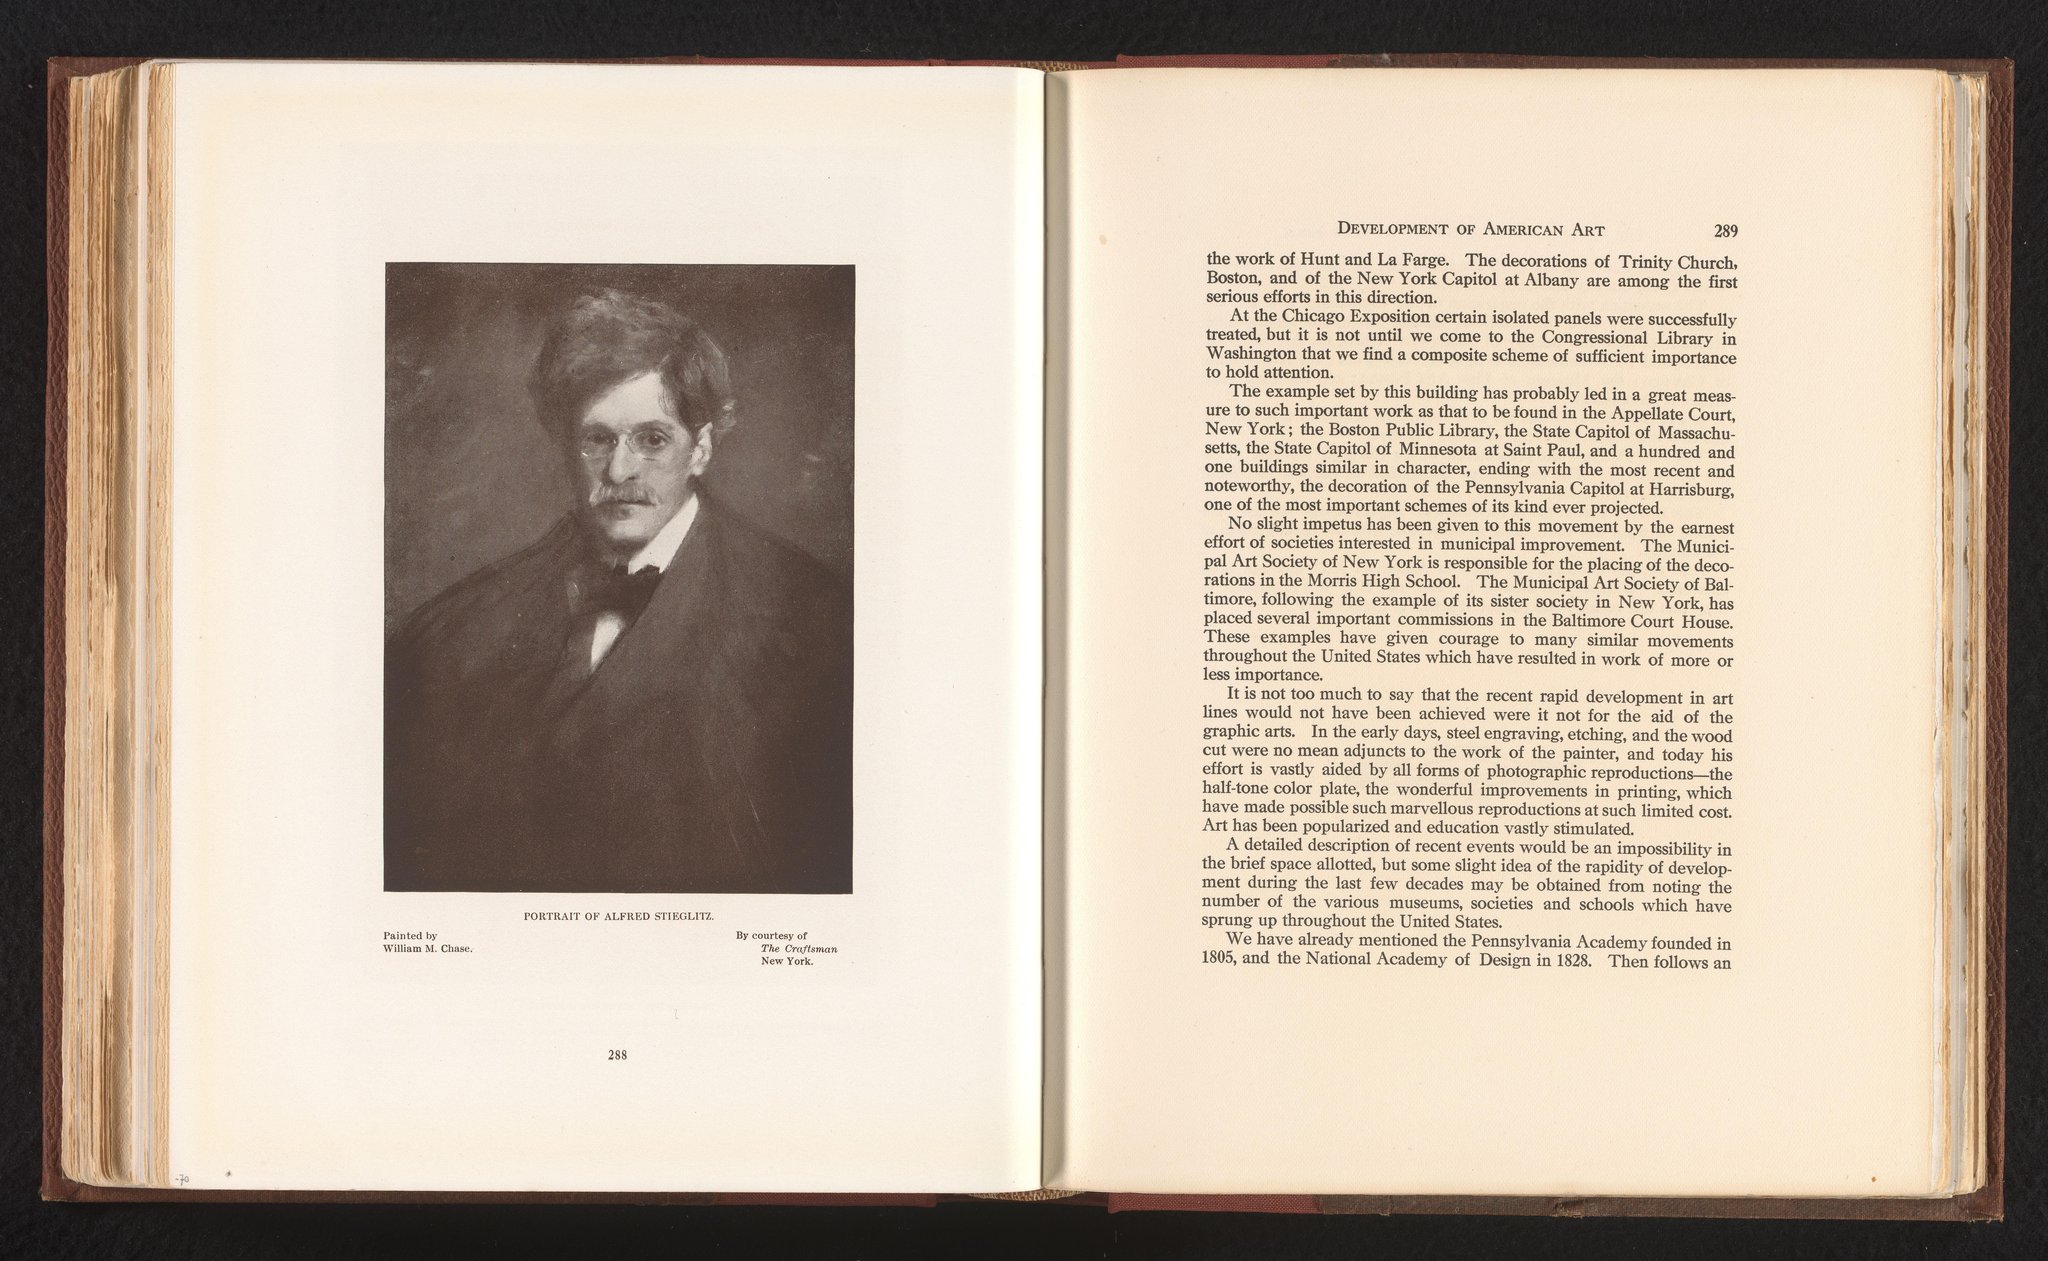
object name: photomechanical print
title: Reproductie van een geschilderd portret van Alfred Stieglitz door William Merritt Chase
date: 1904-1909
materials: paper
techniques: autotype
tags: new york (city), alfred stieglitz, adult man, historical persons